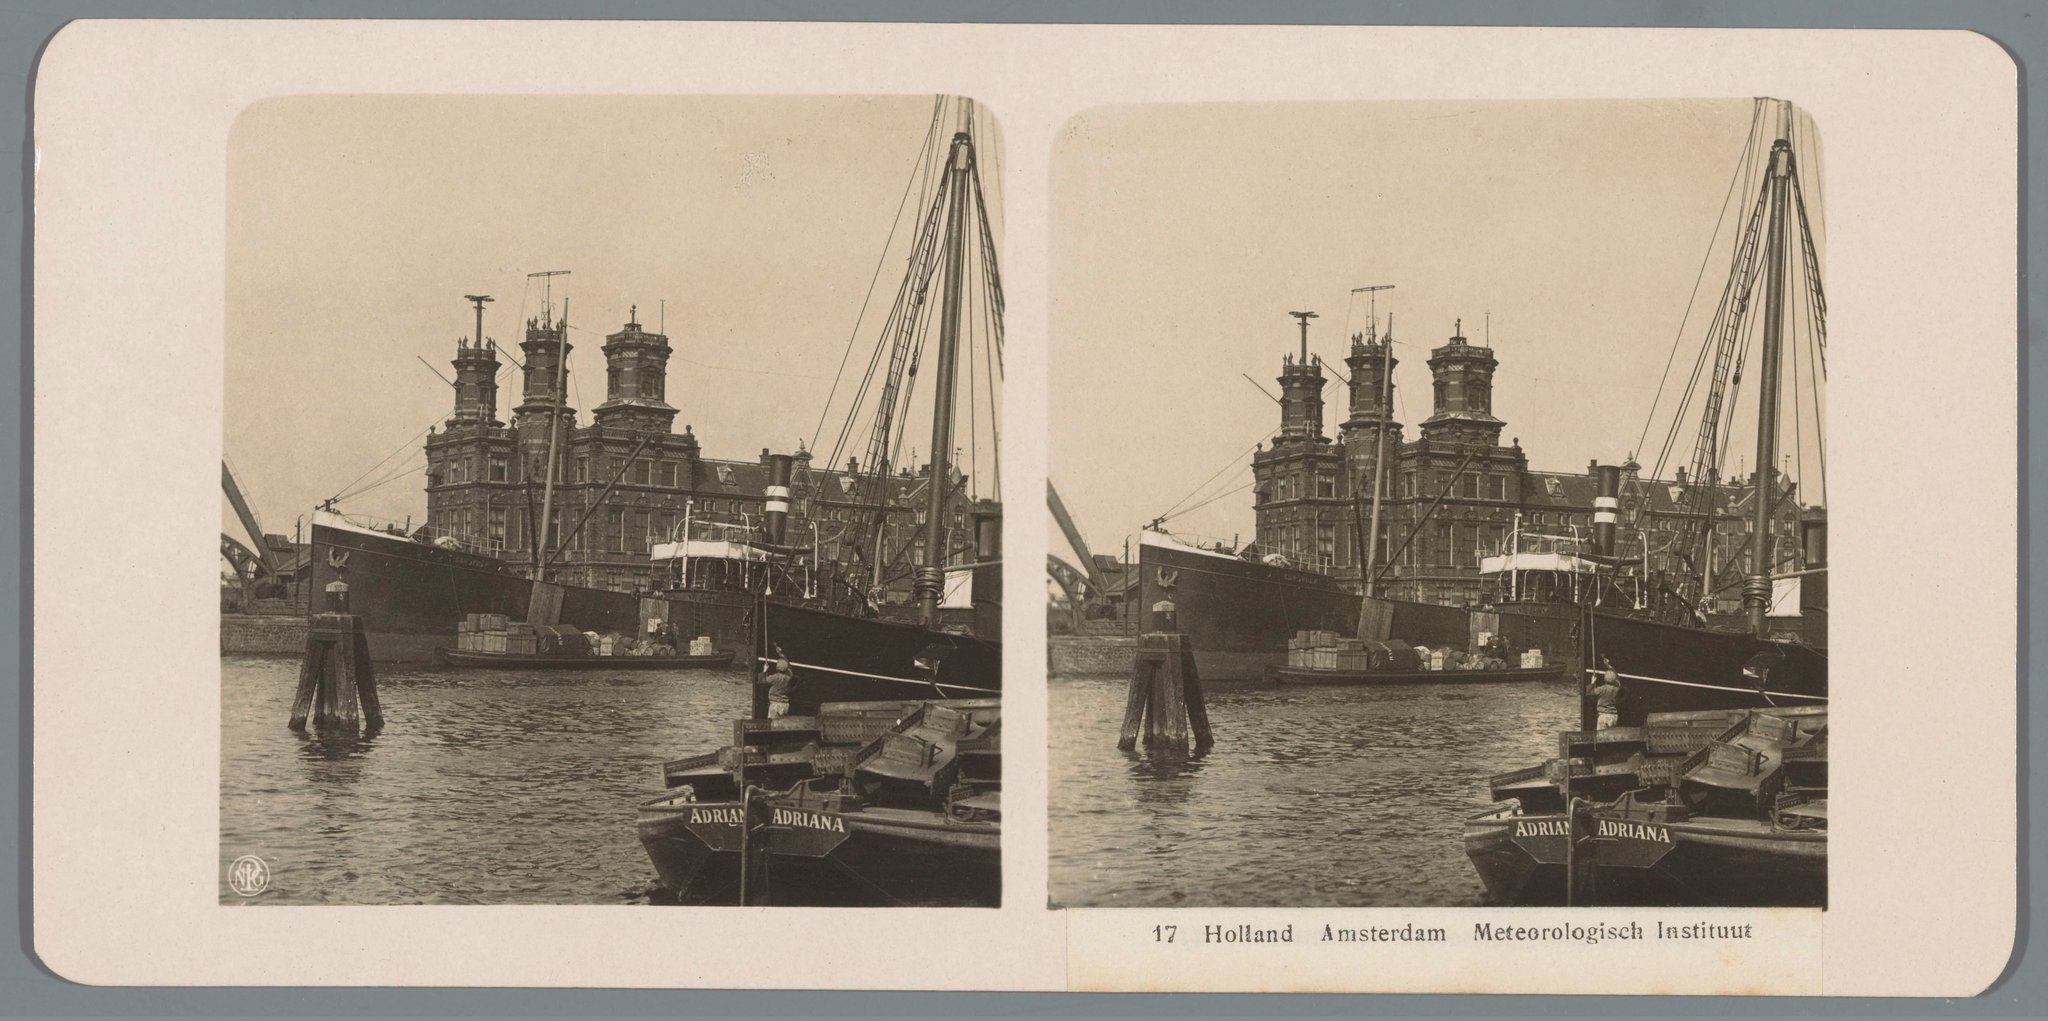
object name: stereograph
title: Gezicht op het Meteorologisch Instituut te Amsterdam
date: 1900-1910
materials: cardboard, photographic support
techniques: gelatin silver print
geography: amsterdam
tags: meteorological observatory, ships (in general), façade (of house or building)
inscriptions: number: ‘17’, inscription: ‘NPG’